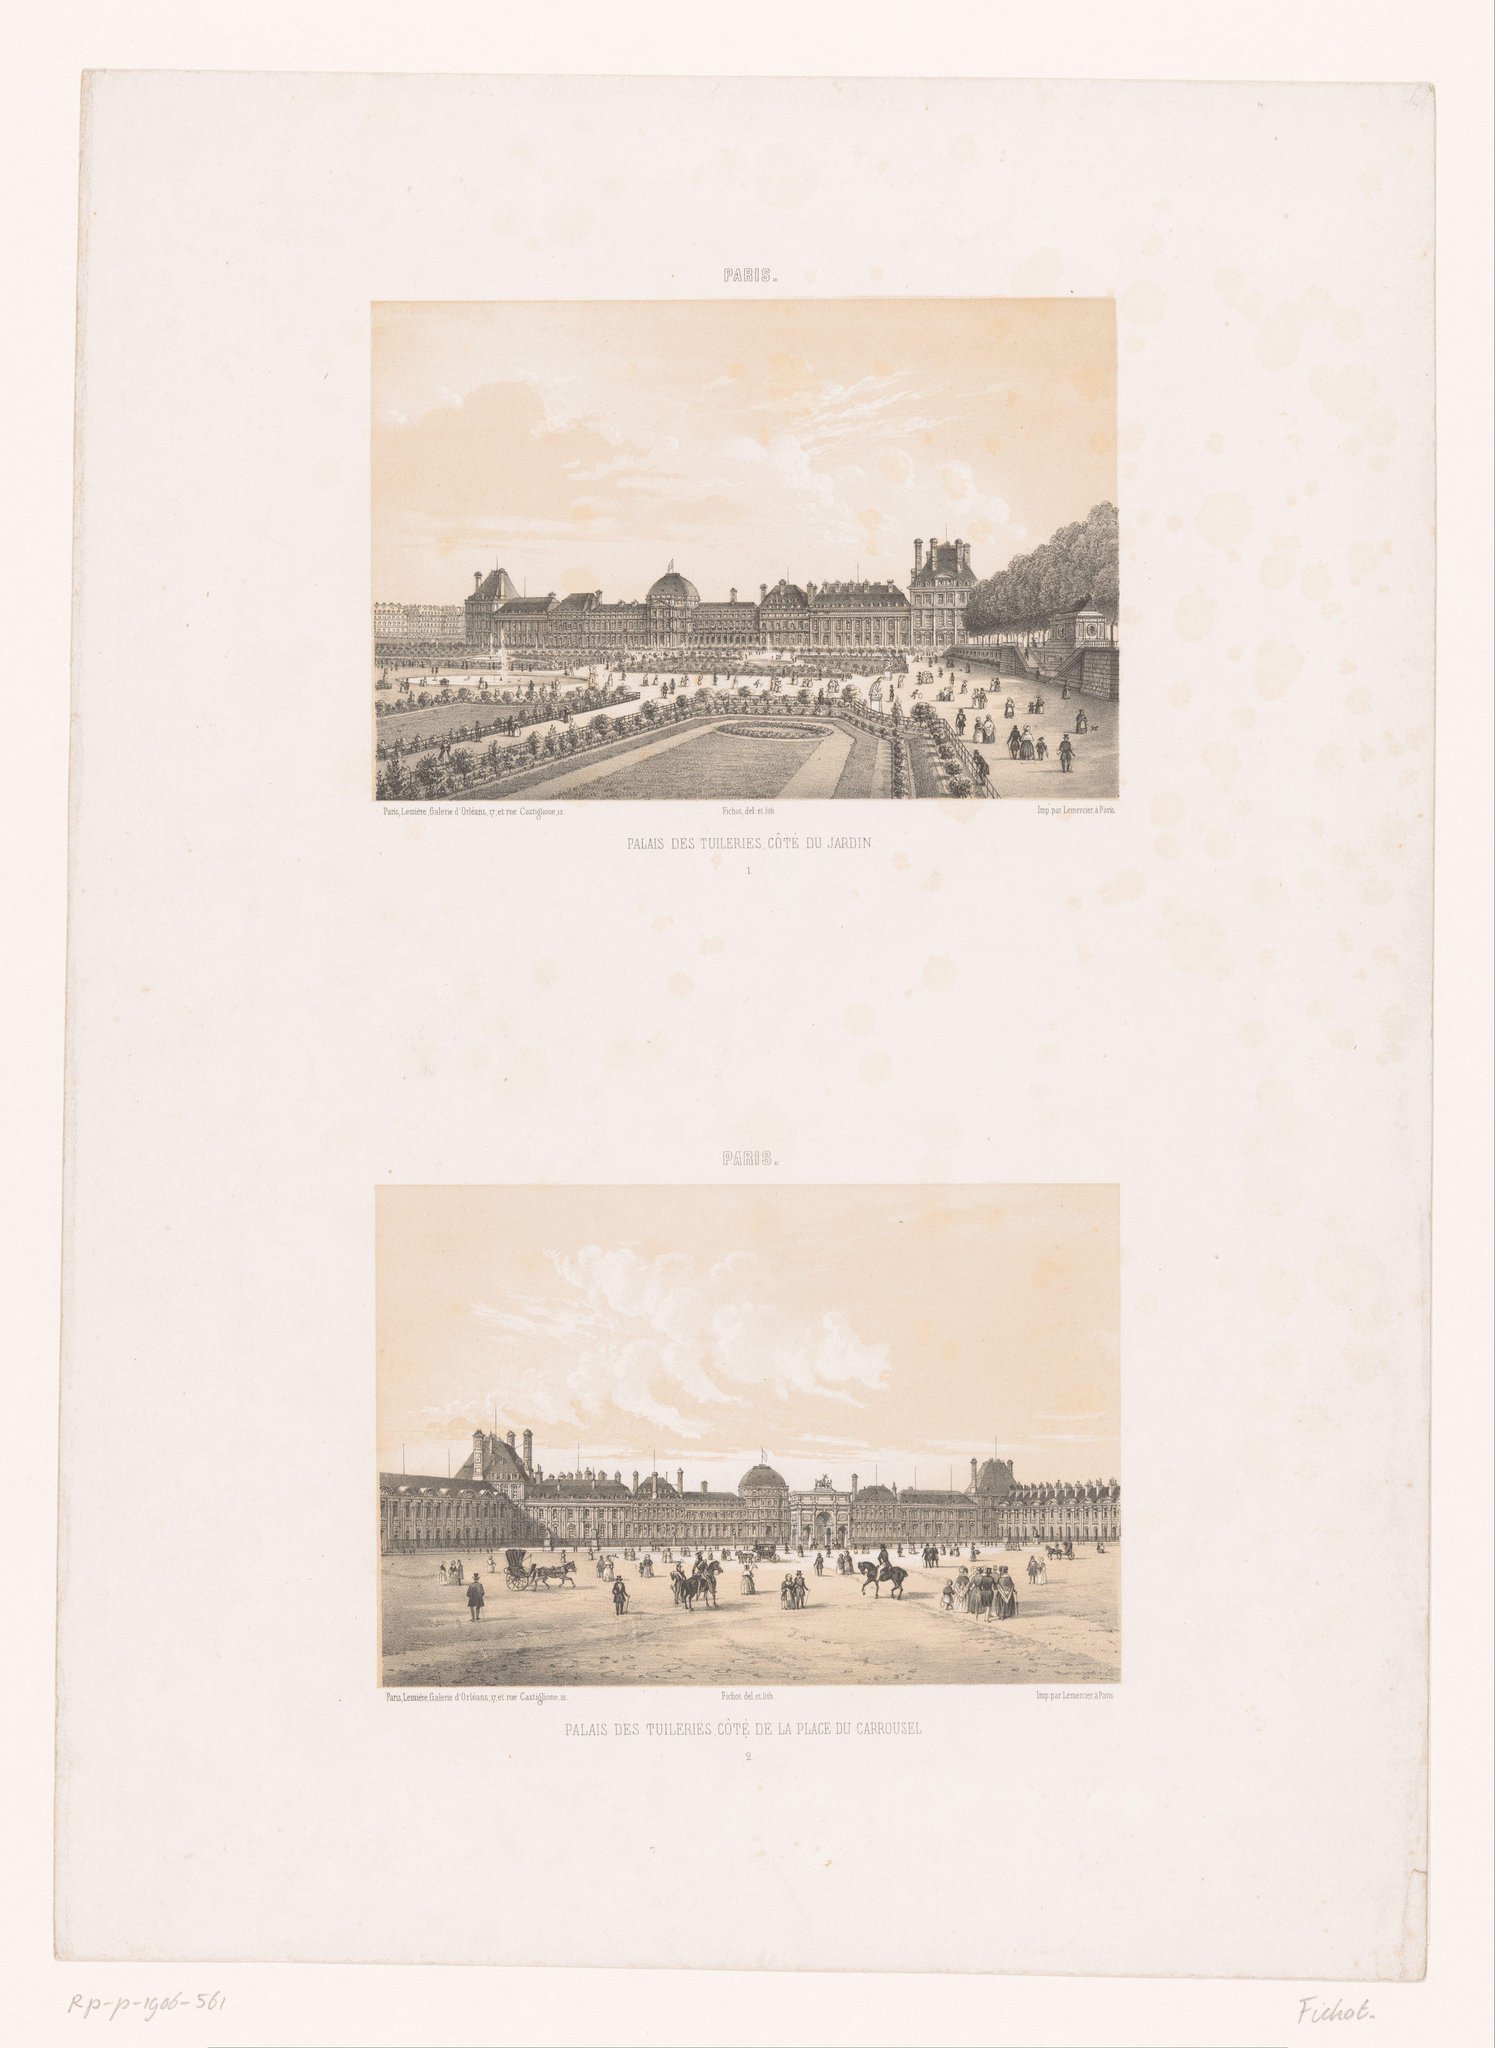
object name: print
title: Palais des Tuileries, côté de la Place du Carrousel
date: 1860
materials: paper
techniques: tone lithography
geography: paris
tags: public gardens, park (+ city(-scape) with figures, staffage), palace, square, place, circus, etc. (+ city(-scape) with figures, staffage)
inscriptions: collector's mark: Lugt 2228a